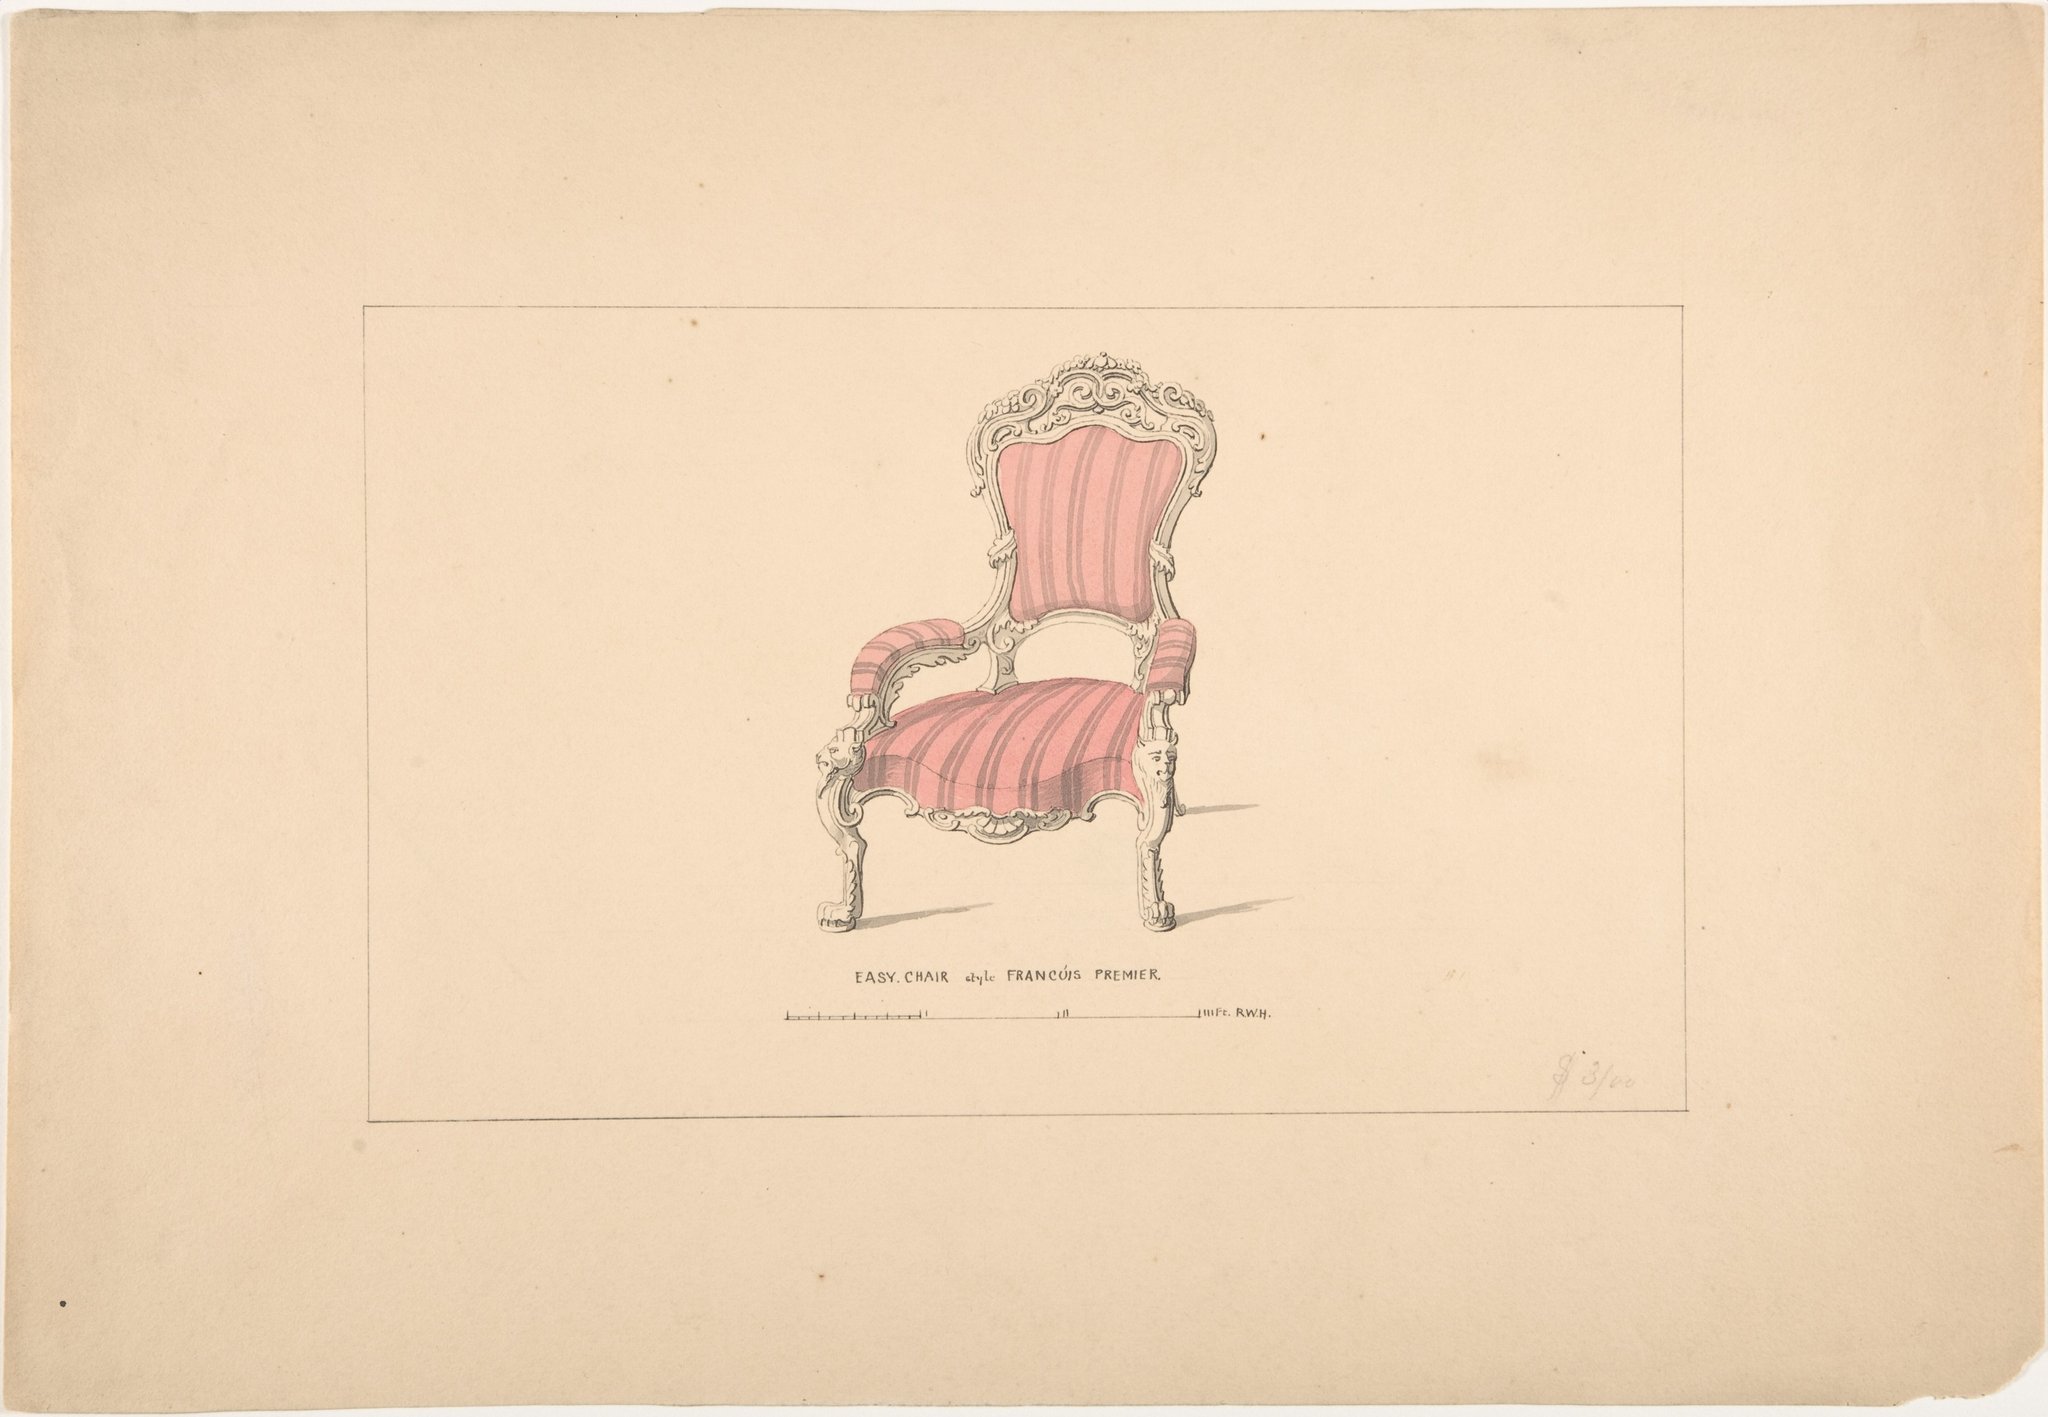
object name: drawing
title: Design for Easy Chair, François Premier Style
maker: robert william hume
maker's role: artist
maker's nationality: british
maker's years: 1816-1904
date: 1835-1900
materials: graphite, ink, watercolor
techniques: pen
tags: chairs